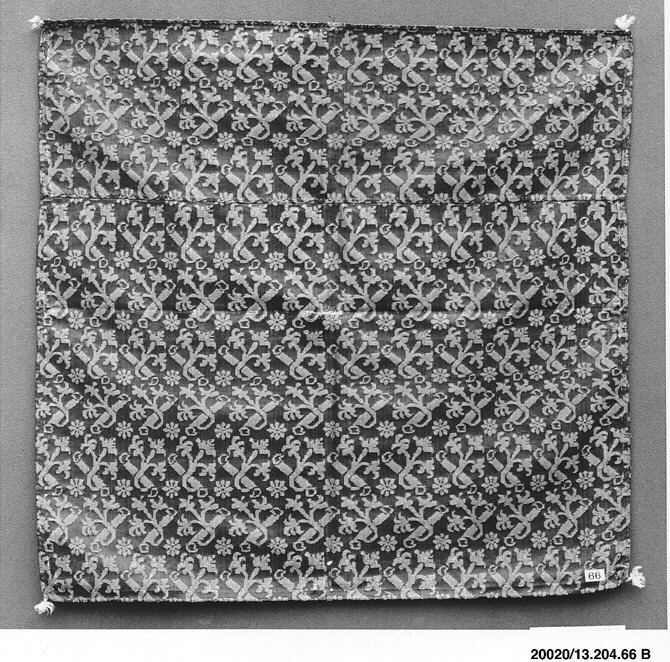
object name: piece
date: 1567-1600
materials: silk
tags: flowers,leaves